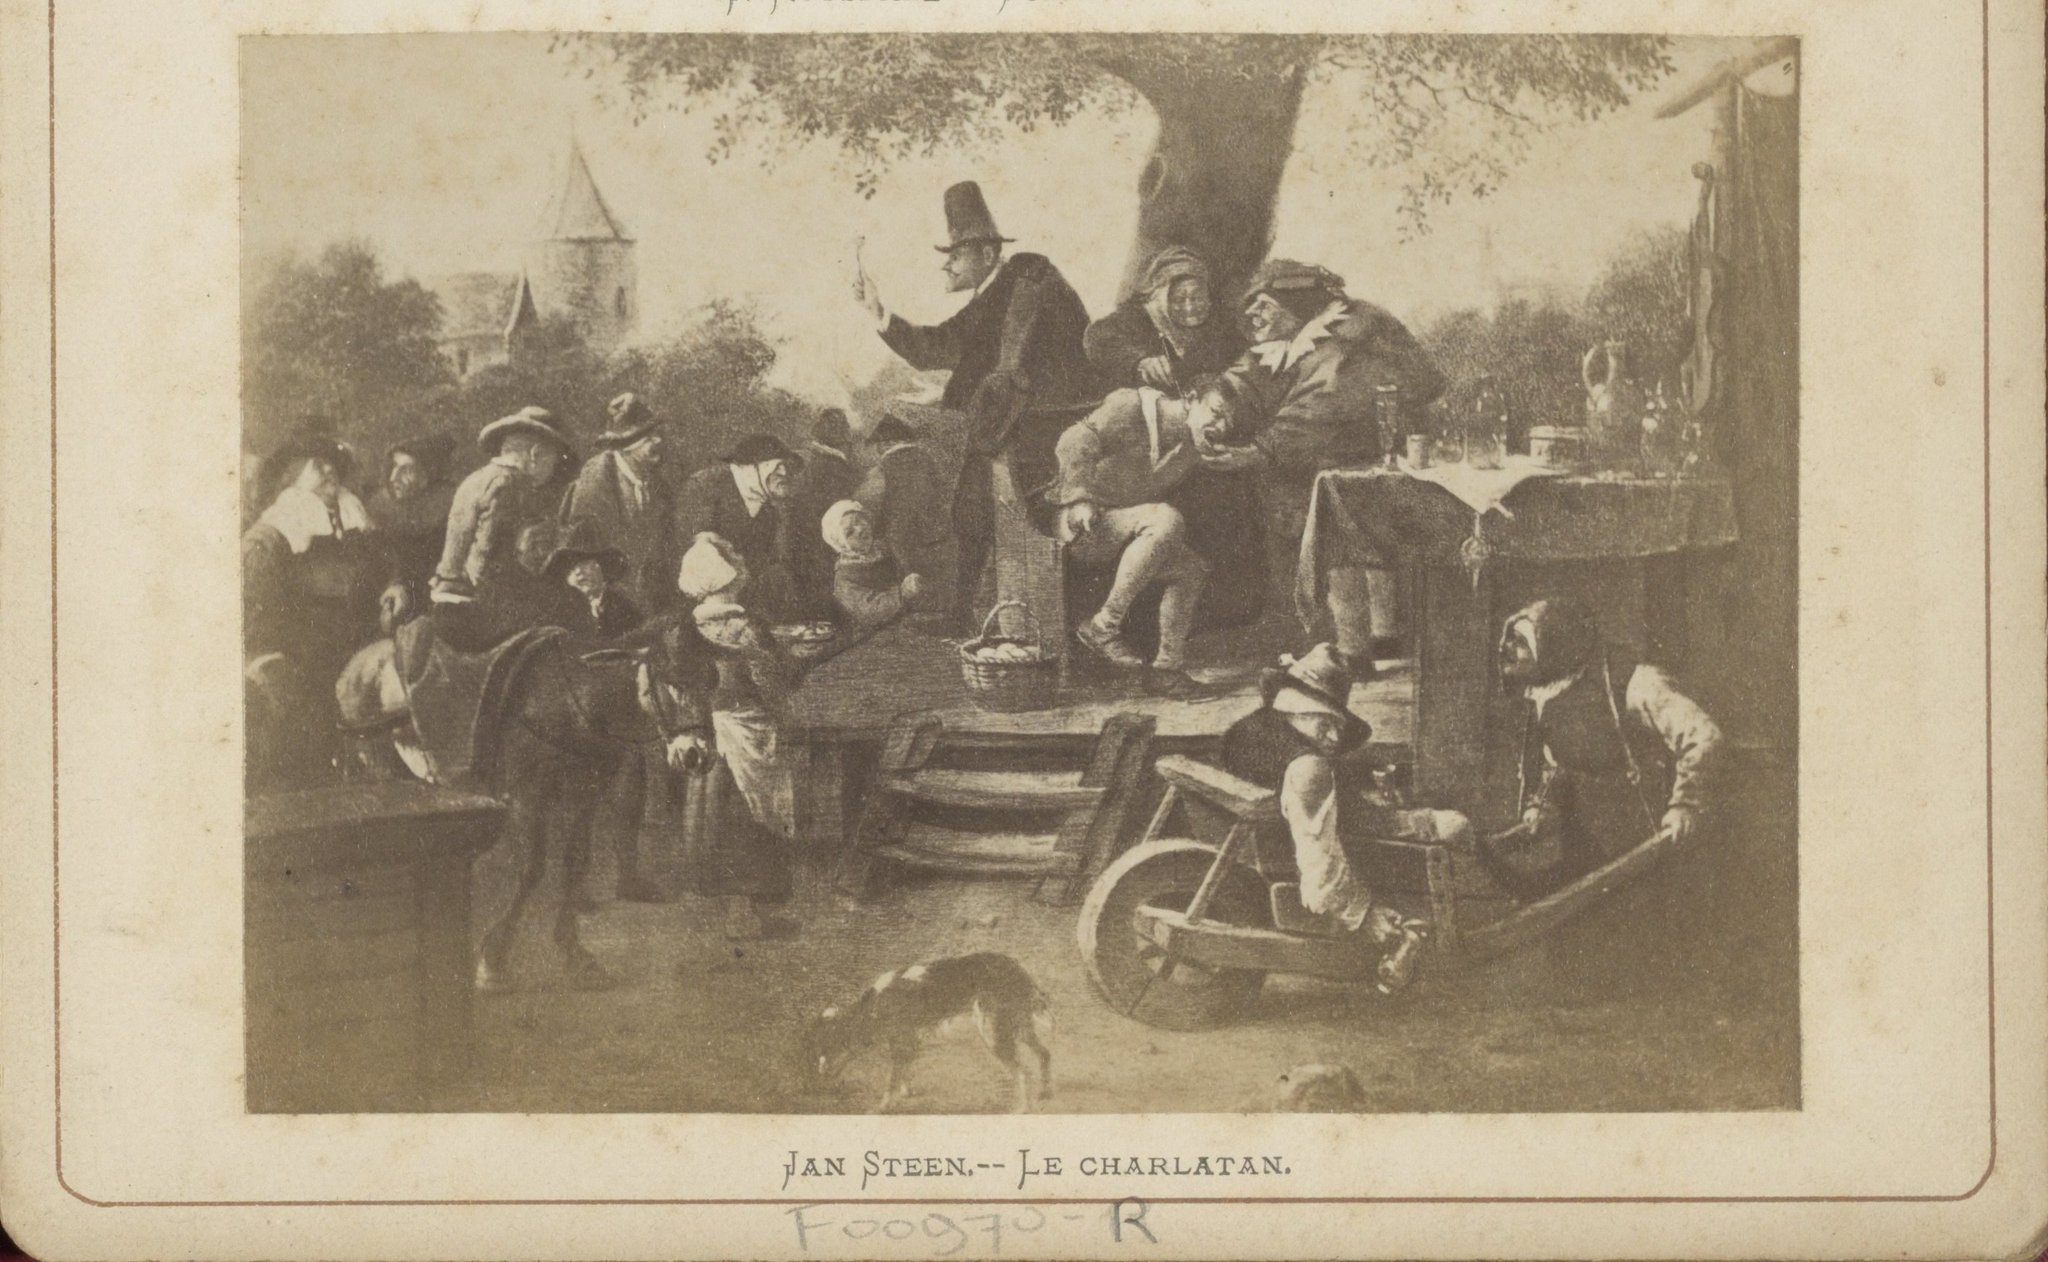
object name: photograph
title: Fotoreproductie van (vermoedelijk) een prent van De kwakzalver van Jan Steen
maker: andries jager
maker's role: publisher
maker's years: 1825-1905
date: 1875-1910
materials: cardboard, paper, photographic support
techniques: albumen print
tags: hand-cart, quack, charlatan, mountebank, 'saltimbanco', patient, sick person, dog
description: Onderdeel van Leporelloalbum met 28 foto's van Amsterdam en omstreken.